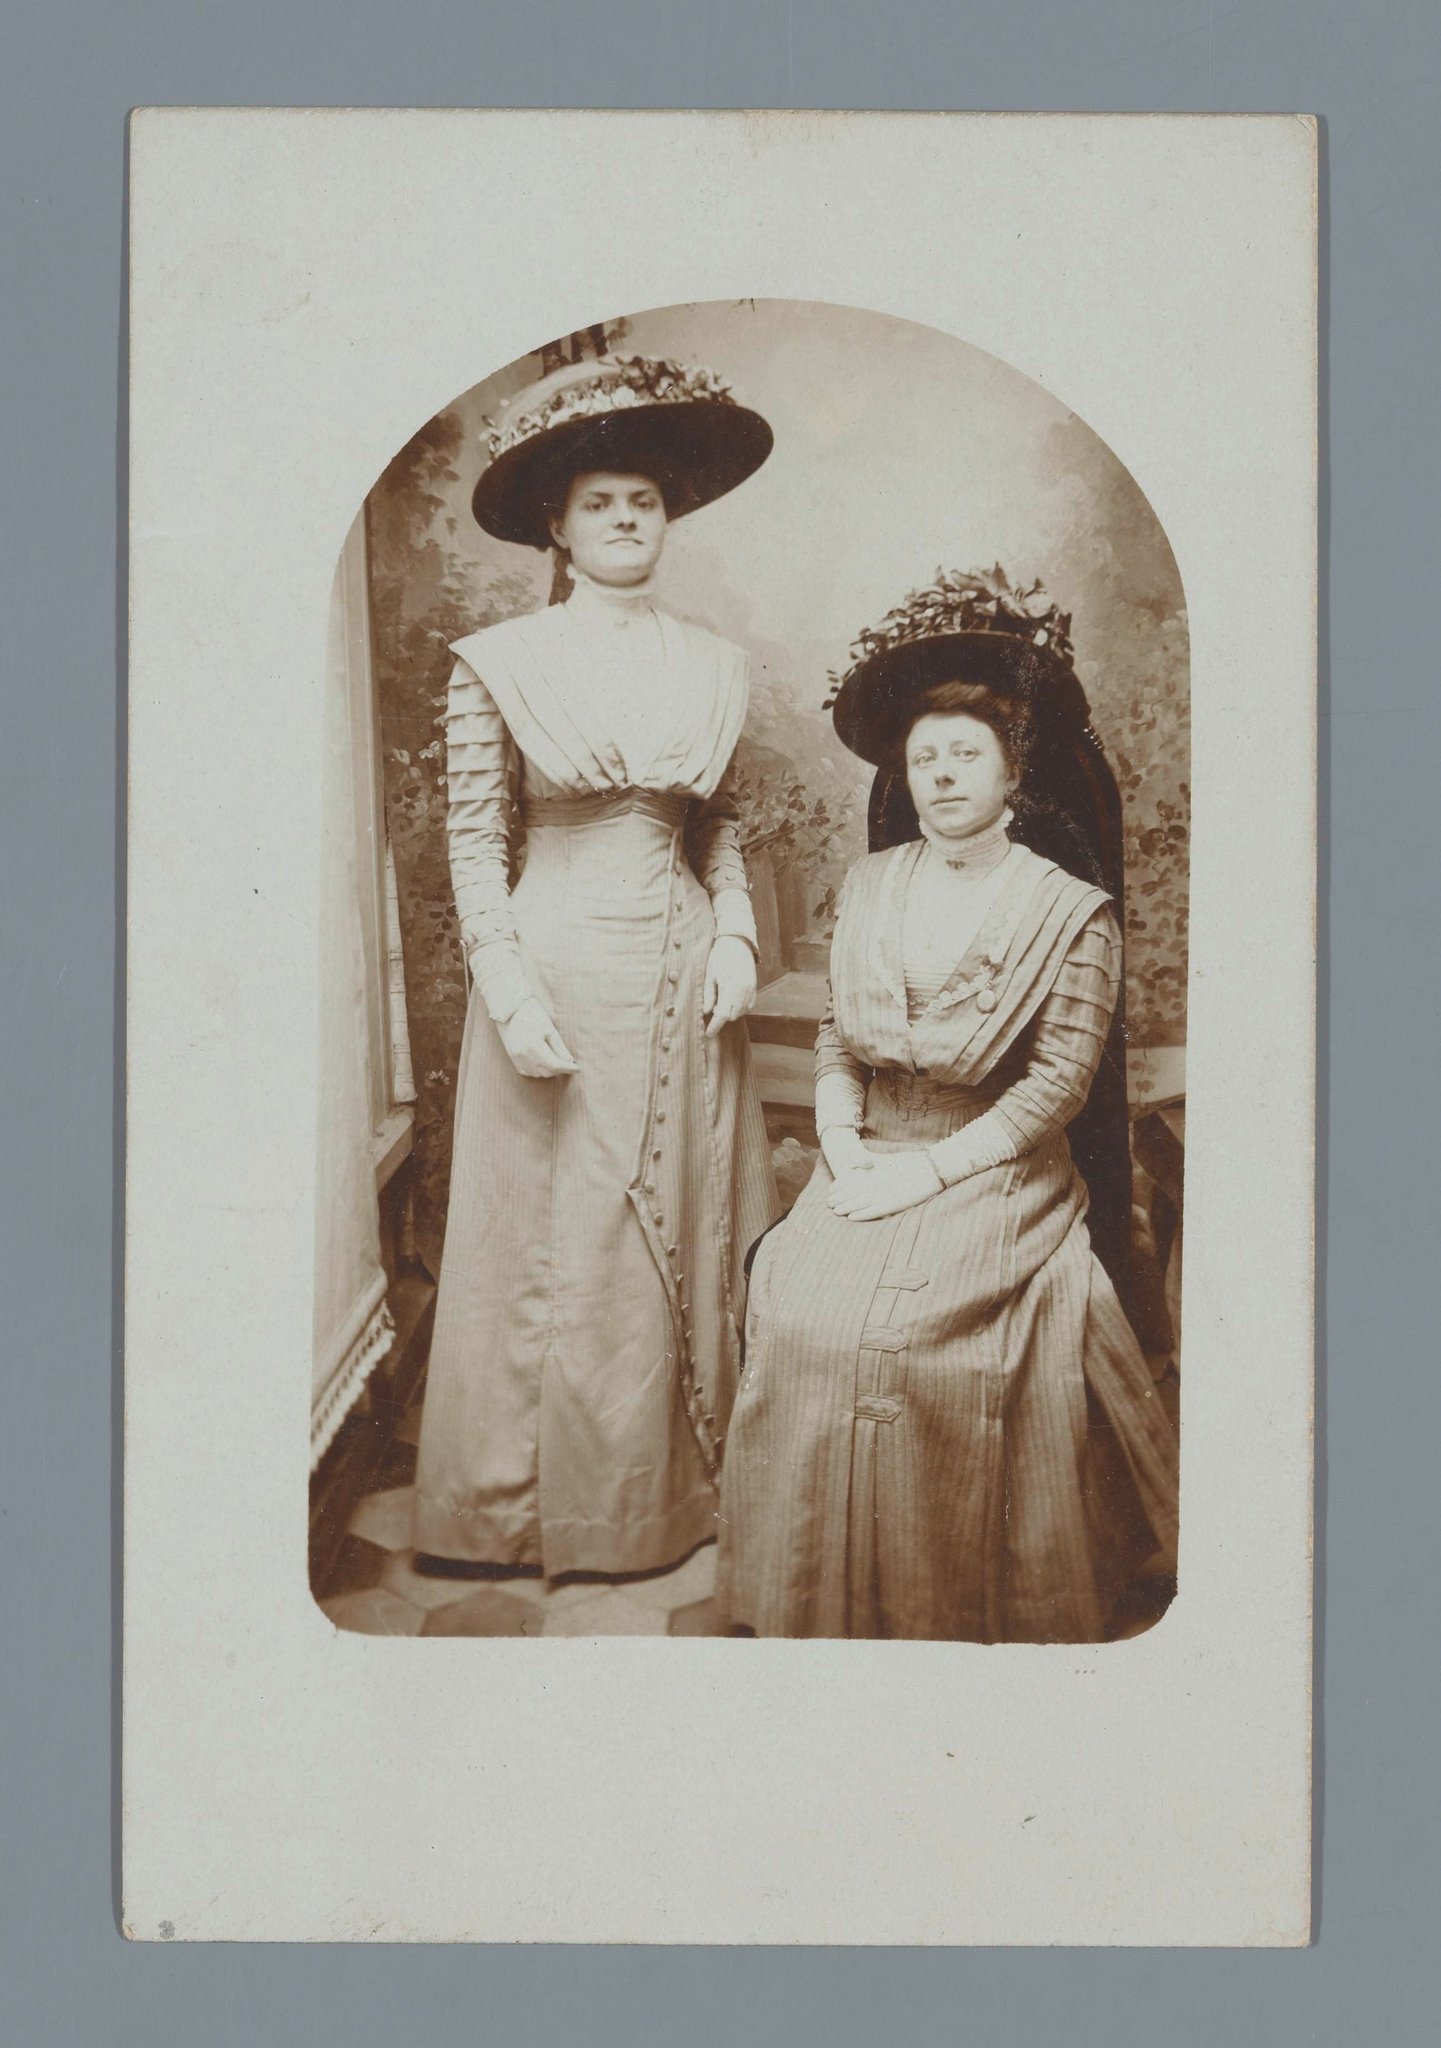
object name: ansichtkaart, prentbriefkaart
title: Portret van twee onbekende vrouwen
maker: Anonymous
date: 1907-1915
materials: photographic support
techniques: collodion silver print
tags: adult woman